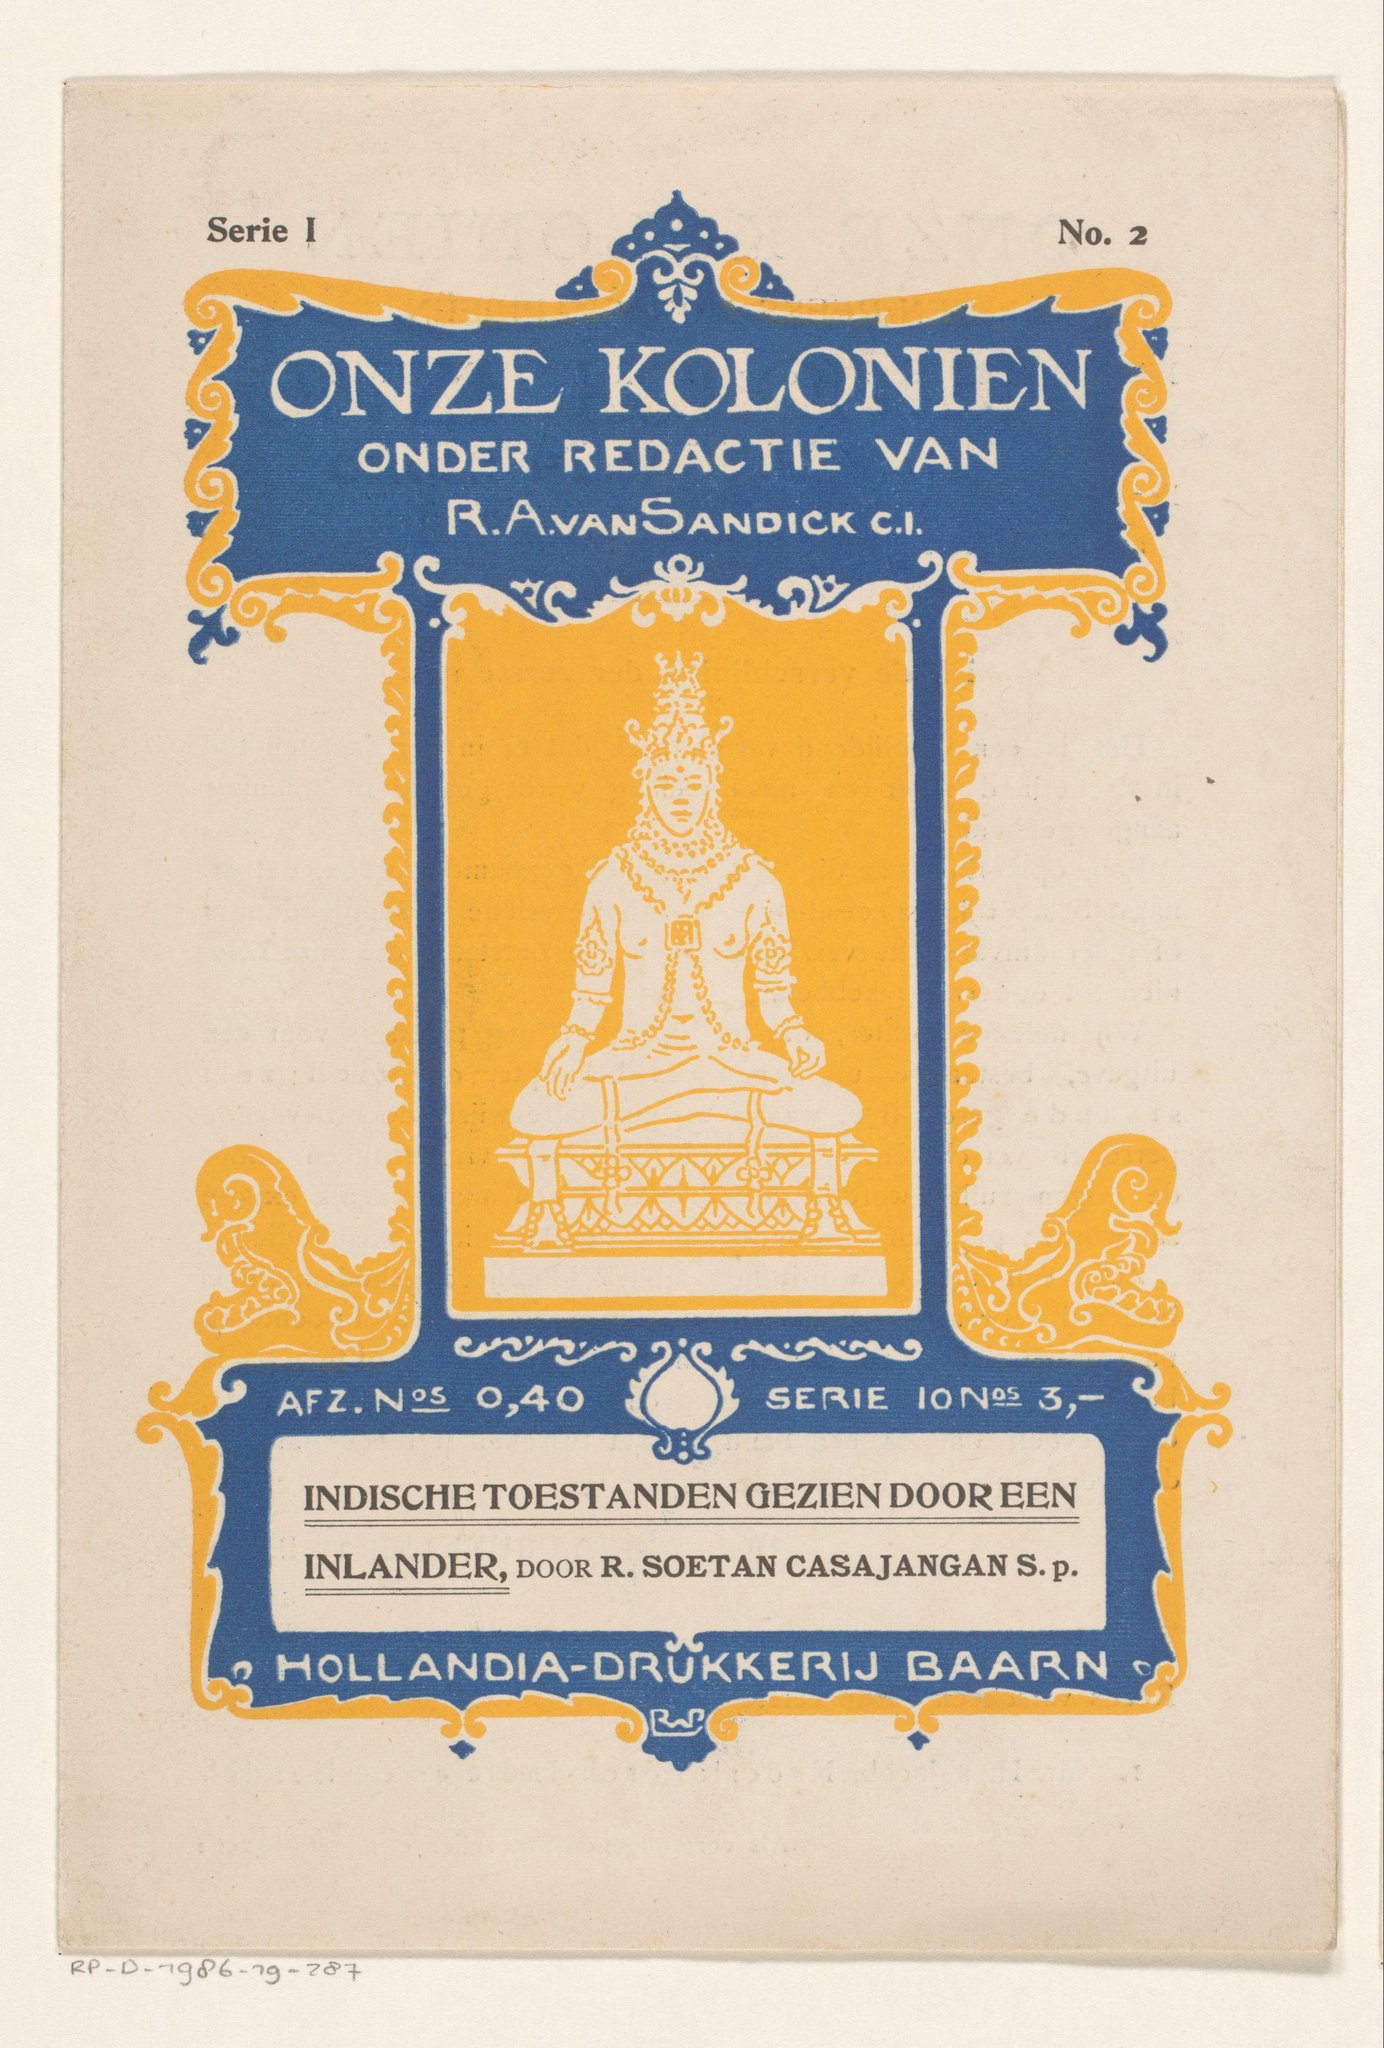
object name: uitgeversprospectus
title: Prospectus van de 'Onze koloniën' reeks van Hollandia-drukkerij te Baarn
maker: reinier willem petrus de vries (1874-1953)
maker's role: draughtsman, print maker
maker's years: 1874-1953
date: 1913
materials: paper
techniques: lithograph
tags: buddha, founder of buddhism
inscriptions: collector's mark: ‘R:MVS.’